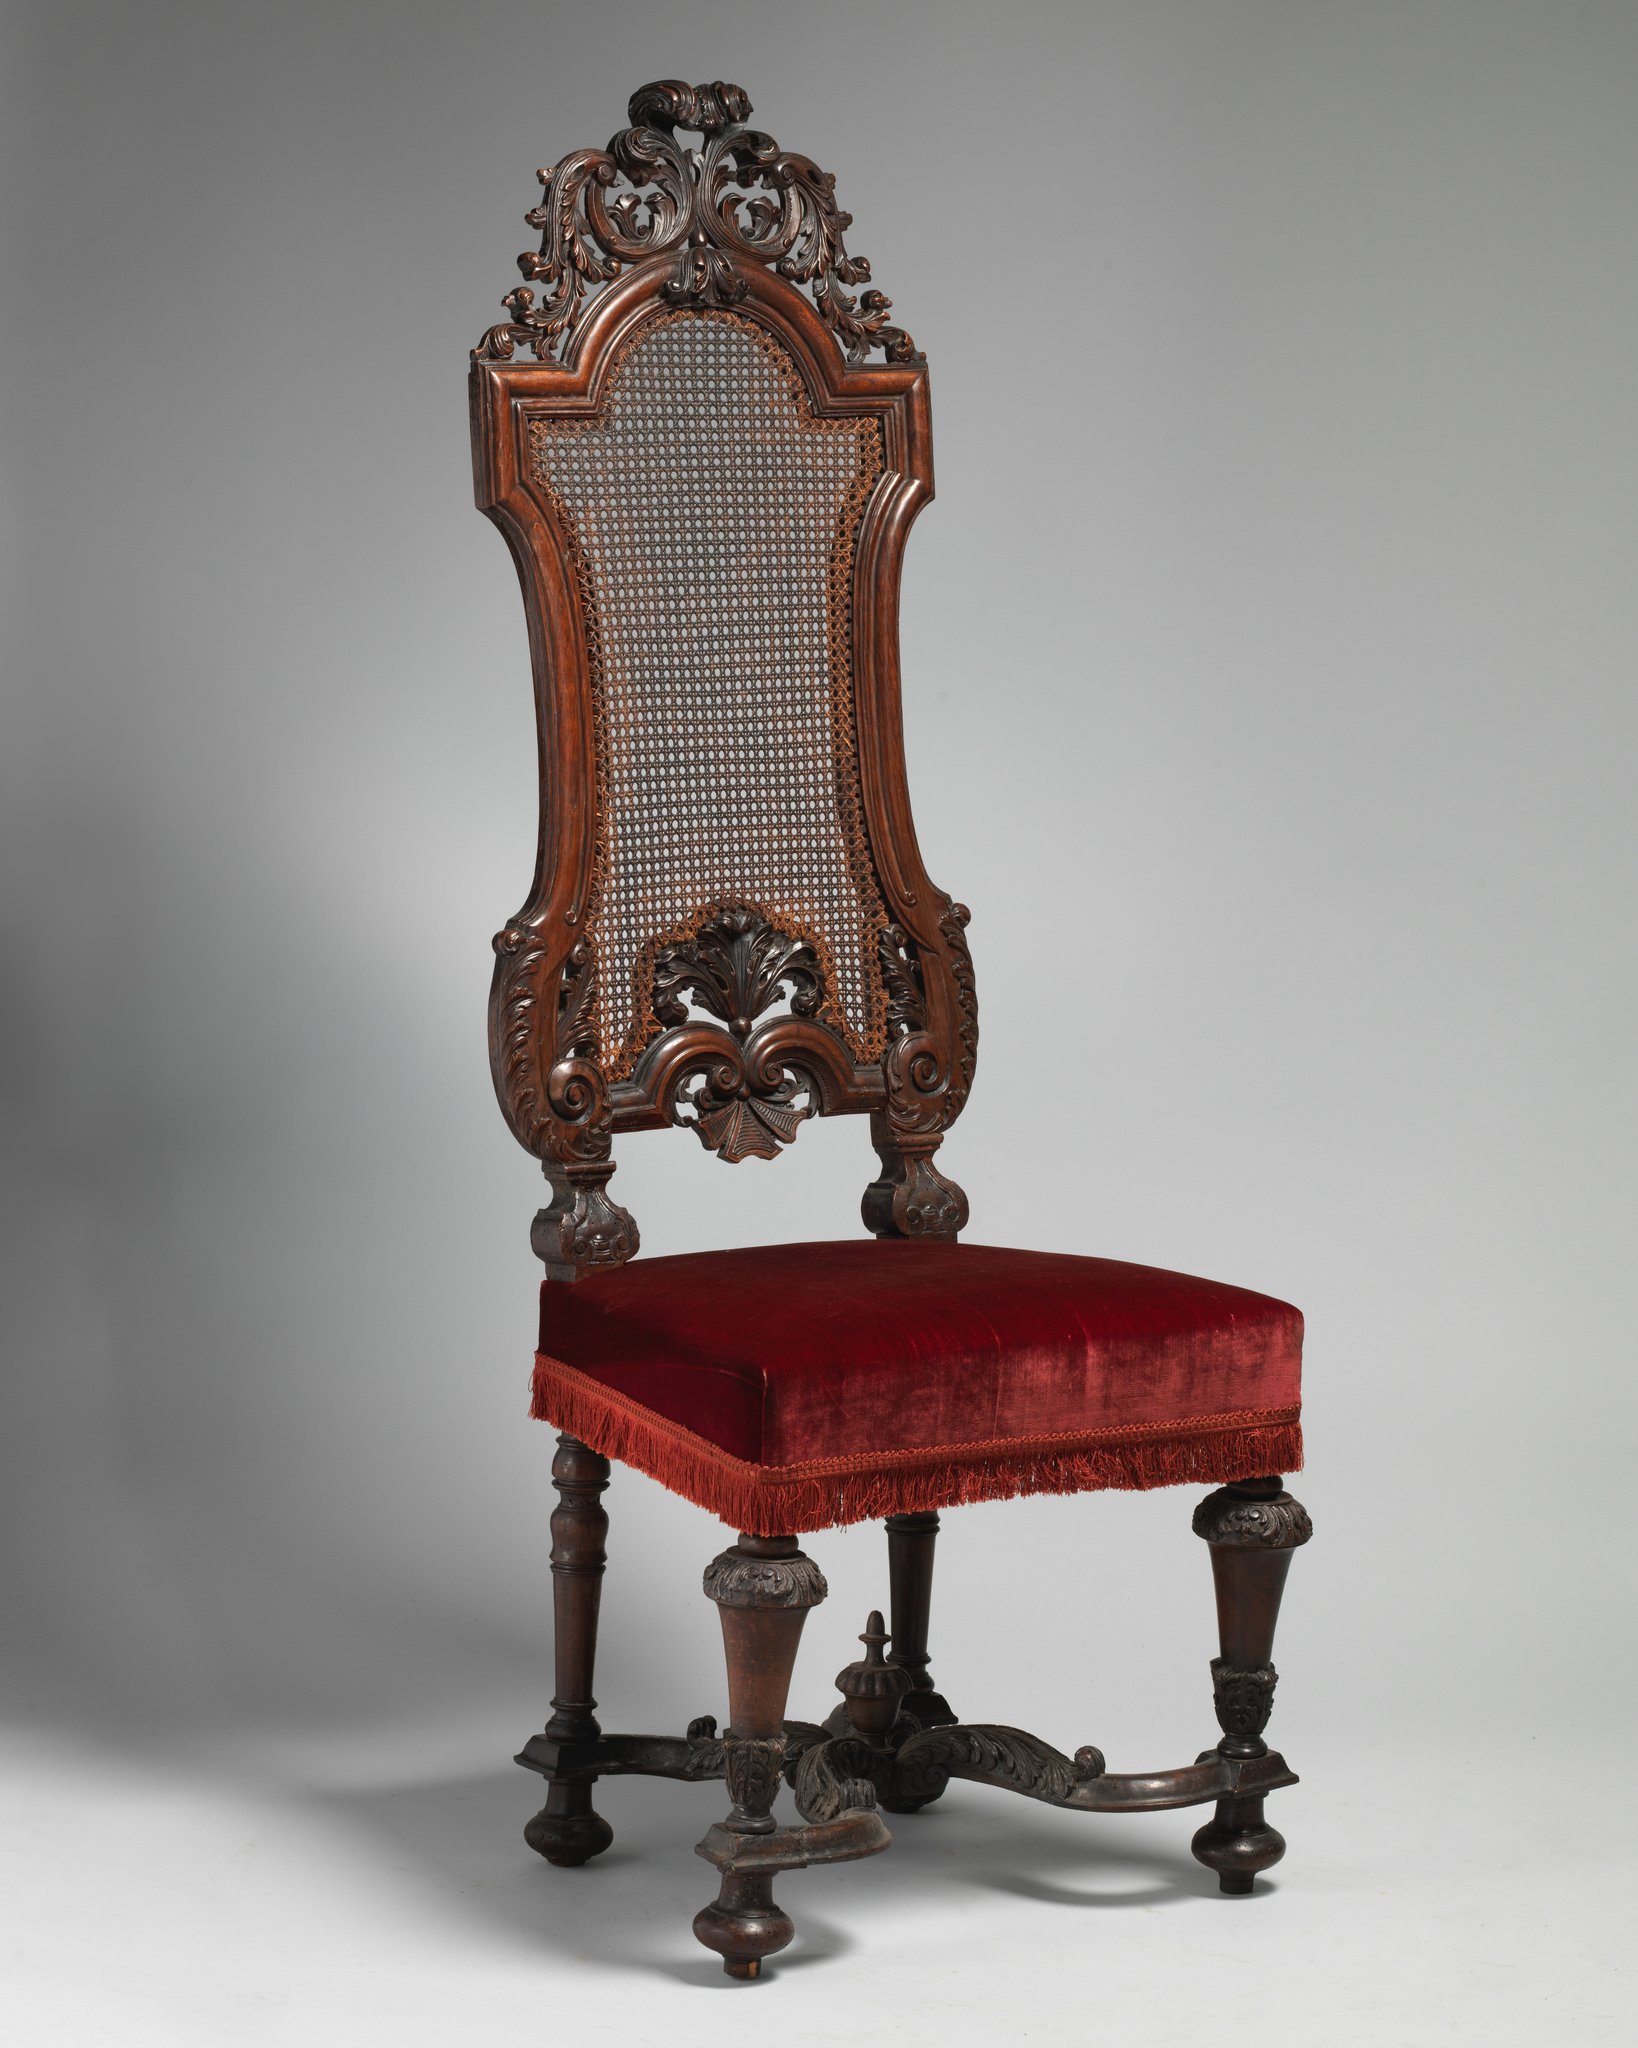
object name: chair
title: Chair (one of a set of six)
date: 1695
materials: velvet, wood